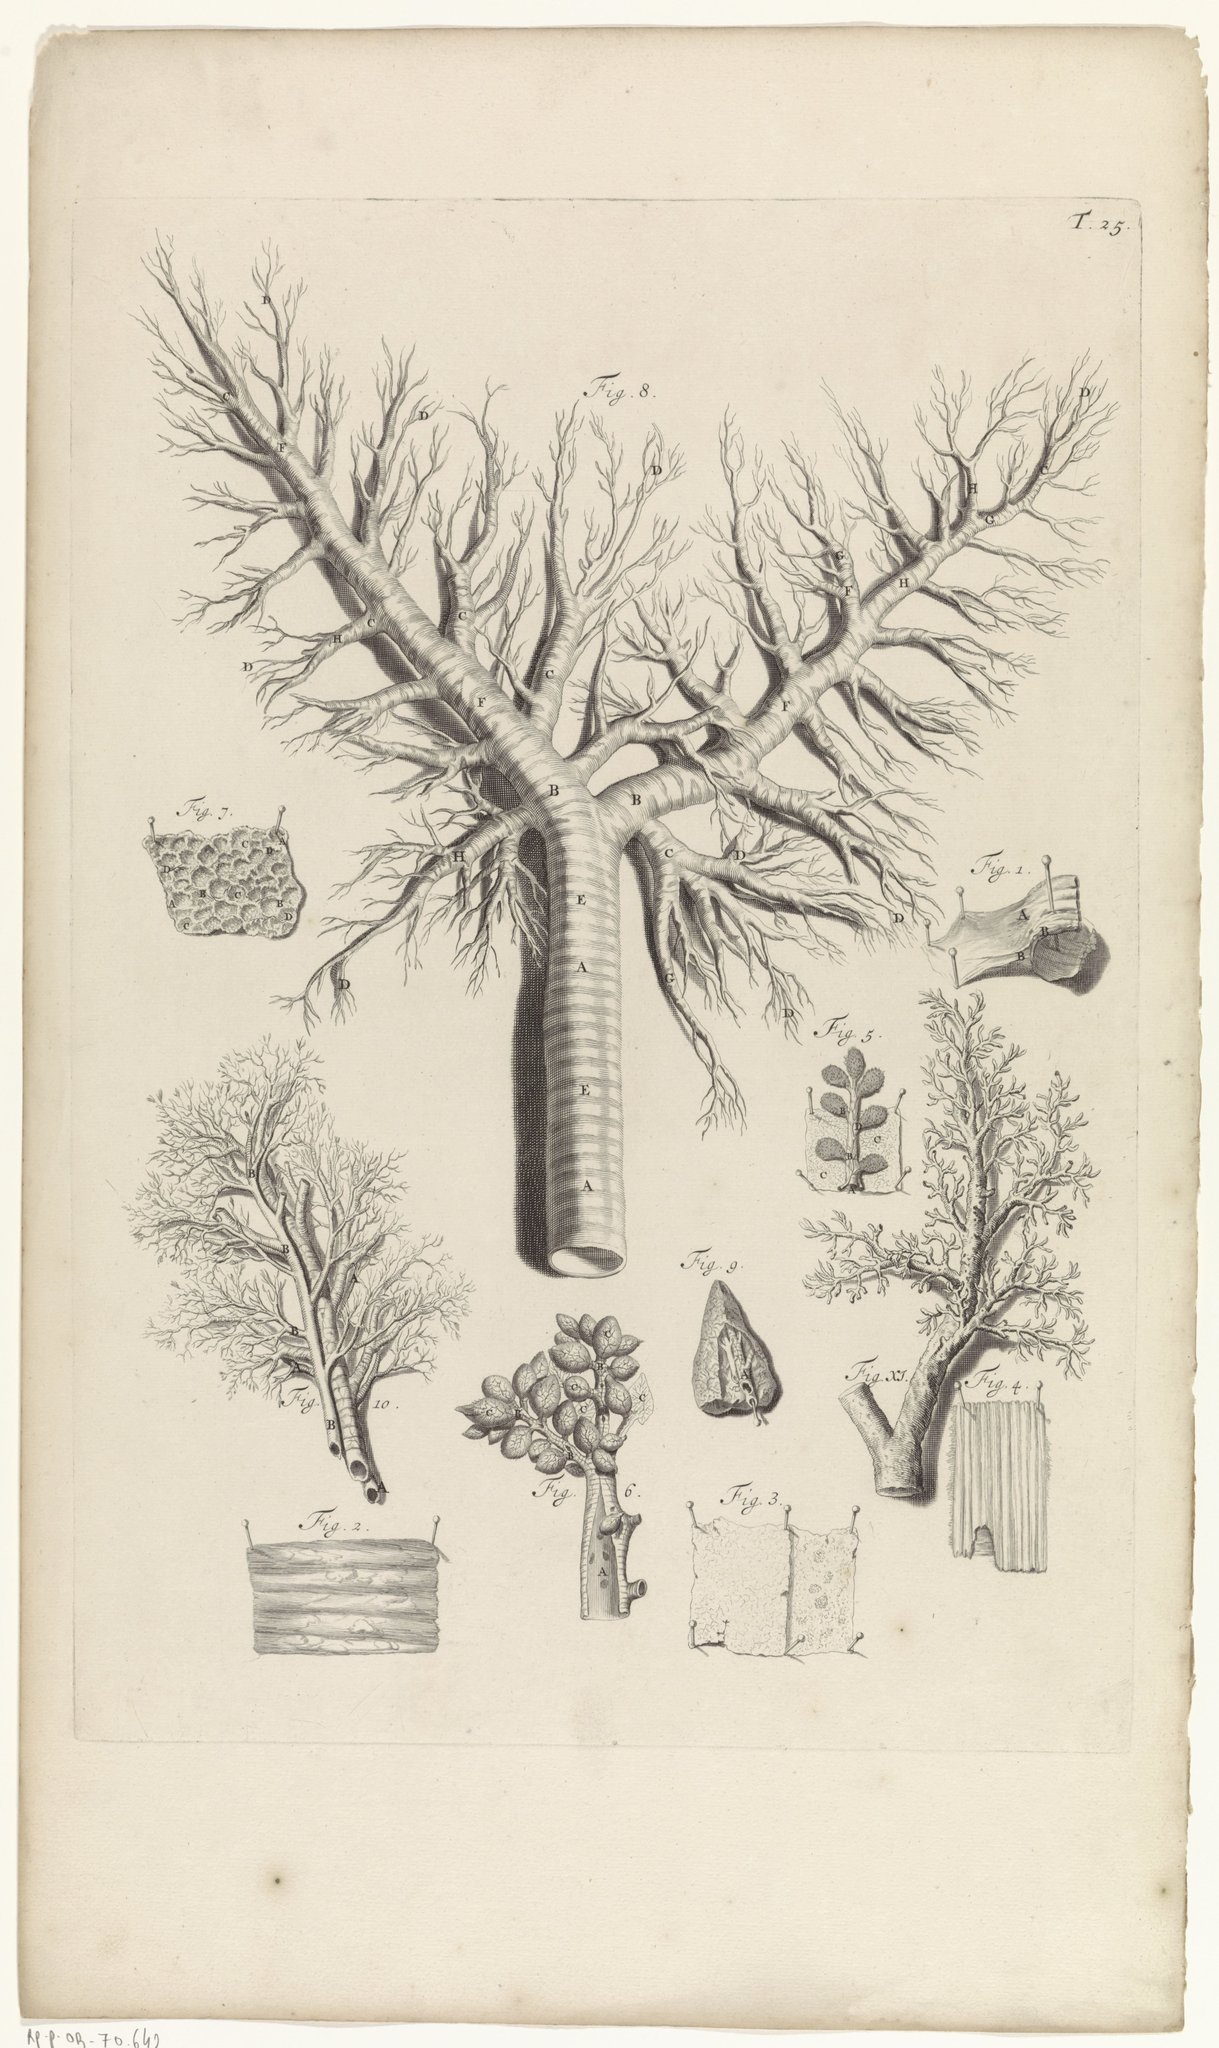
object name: book illustration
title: Anatomische studie van de luchtwegvertakkingen en de longblaasjes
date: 1685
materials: paper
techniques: engraving, etching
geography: amsterdam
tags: lungs, bronchia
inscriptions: collector's mark: Lugt 2228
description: Boekillustratie voor Bidloo, Godefridus. Anatomia humani corporis centum & quinque tabulis, per art. G. de Lairesse ad vivum delineatis, de monstrata, veterum recentiorumque inventis explicata plurimisque, hactenus non detectis, illustrata. Amsterdam: Weduwe Joannes van Someren, Hendrick Boom en erven Dirk Boom, 1685.